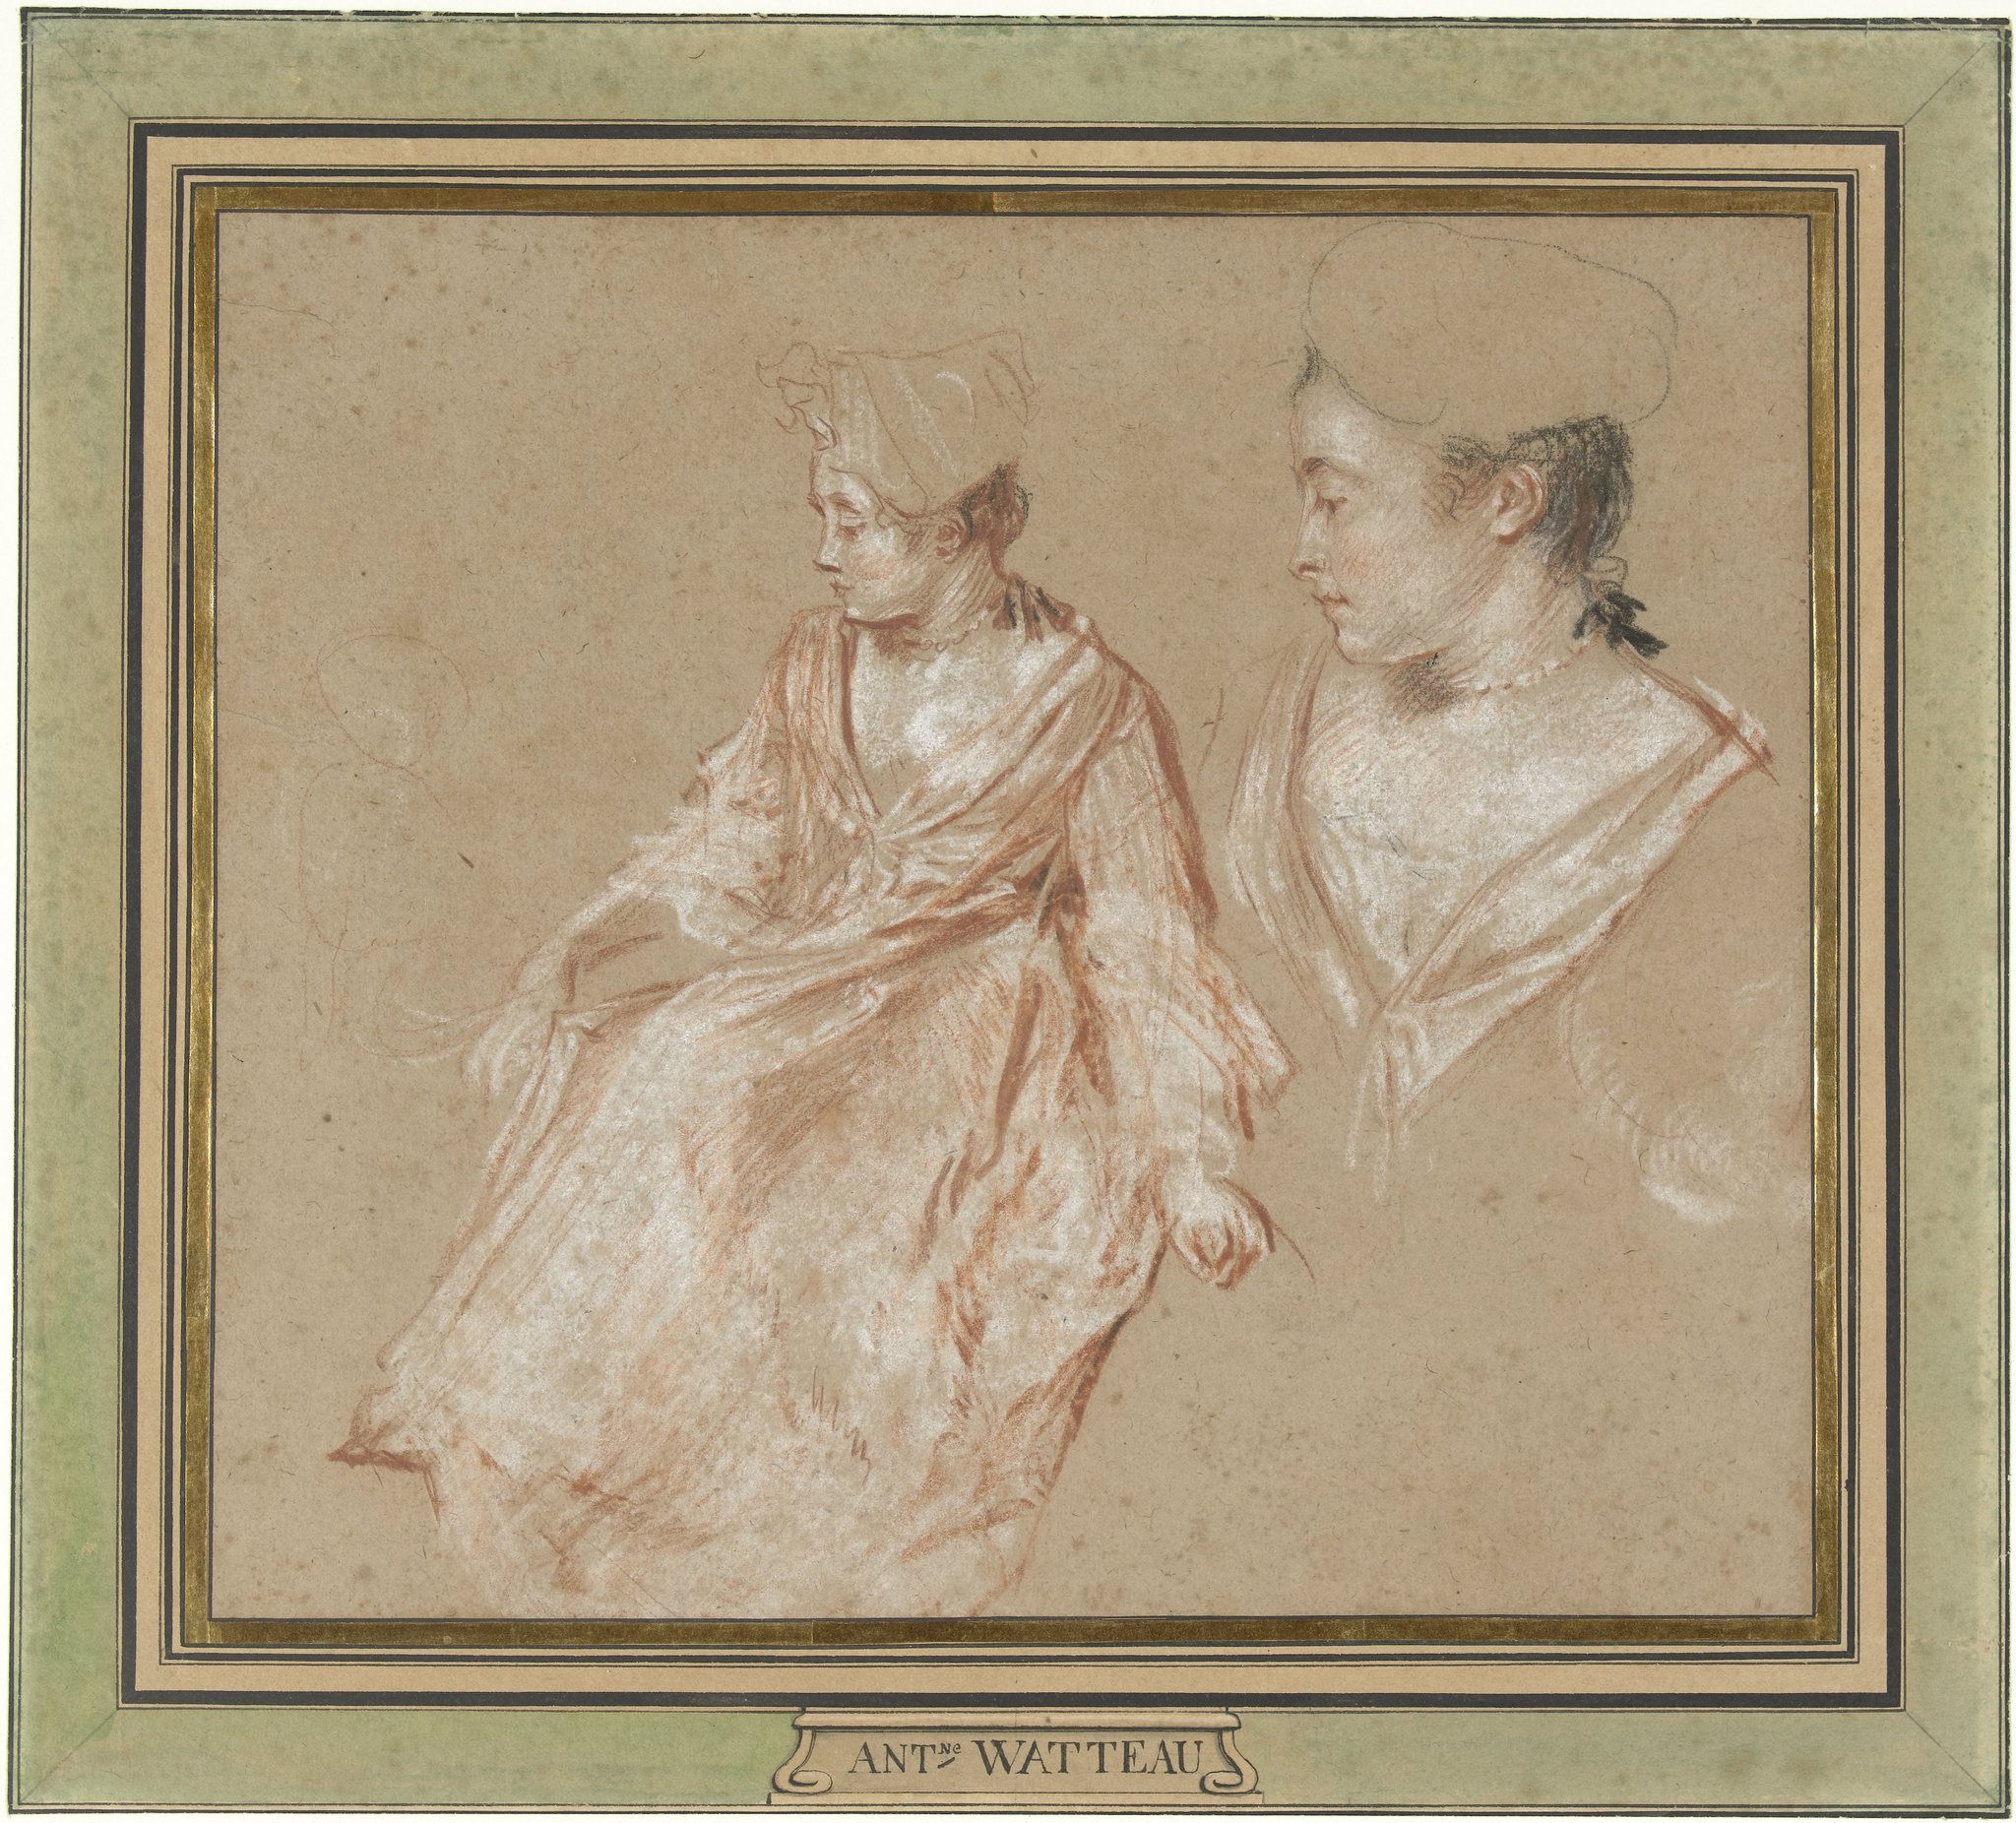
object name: drawing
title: Studies of a Seated Woman and a Detail of Her Head and Shoulders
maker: jean antoine watteau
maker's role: draughtsman, print maker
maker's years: 1684-1721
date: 1716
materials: chalk, paper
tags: sitting figure - aa - female human figure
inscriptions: annotation, pencil: ‘No 4’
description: Gebruikt in twee schilderijen: Assemblée galante (verblijfplaats onbekend) en La famille (part. col.).